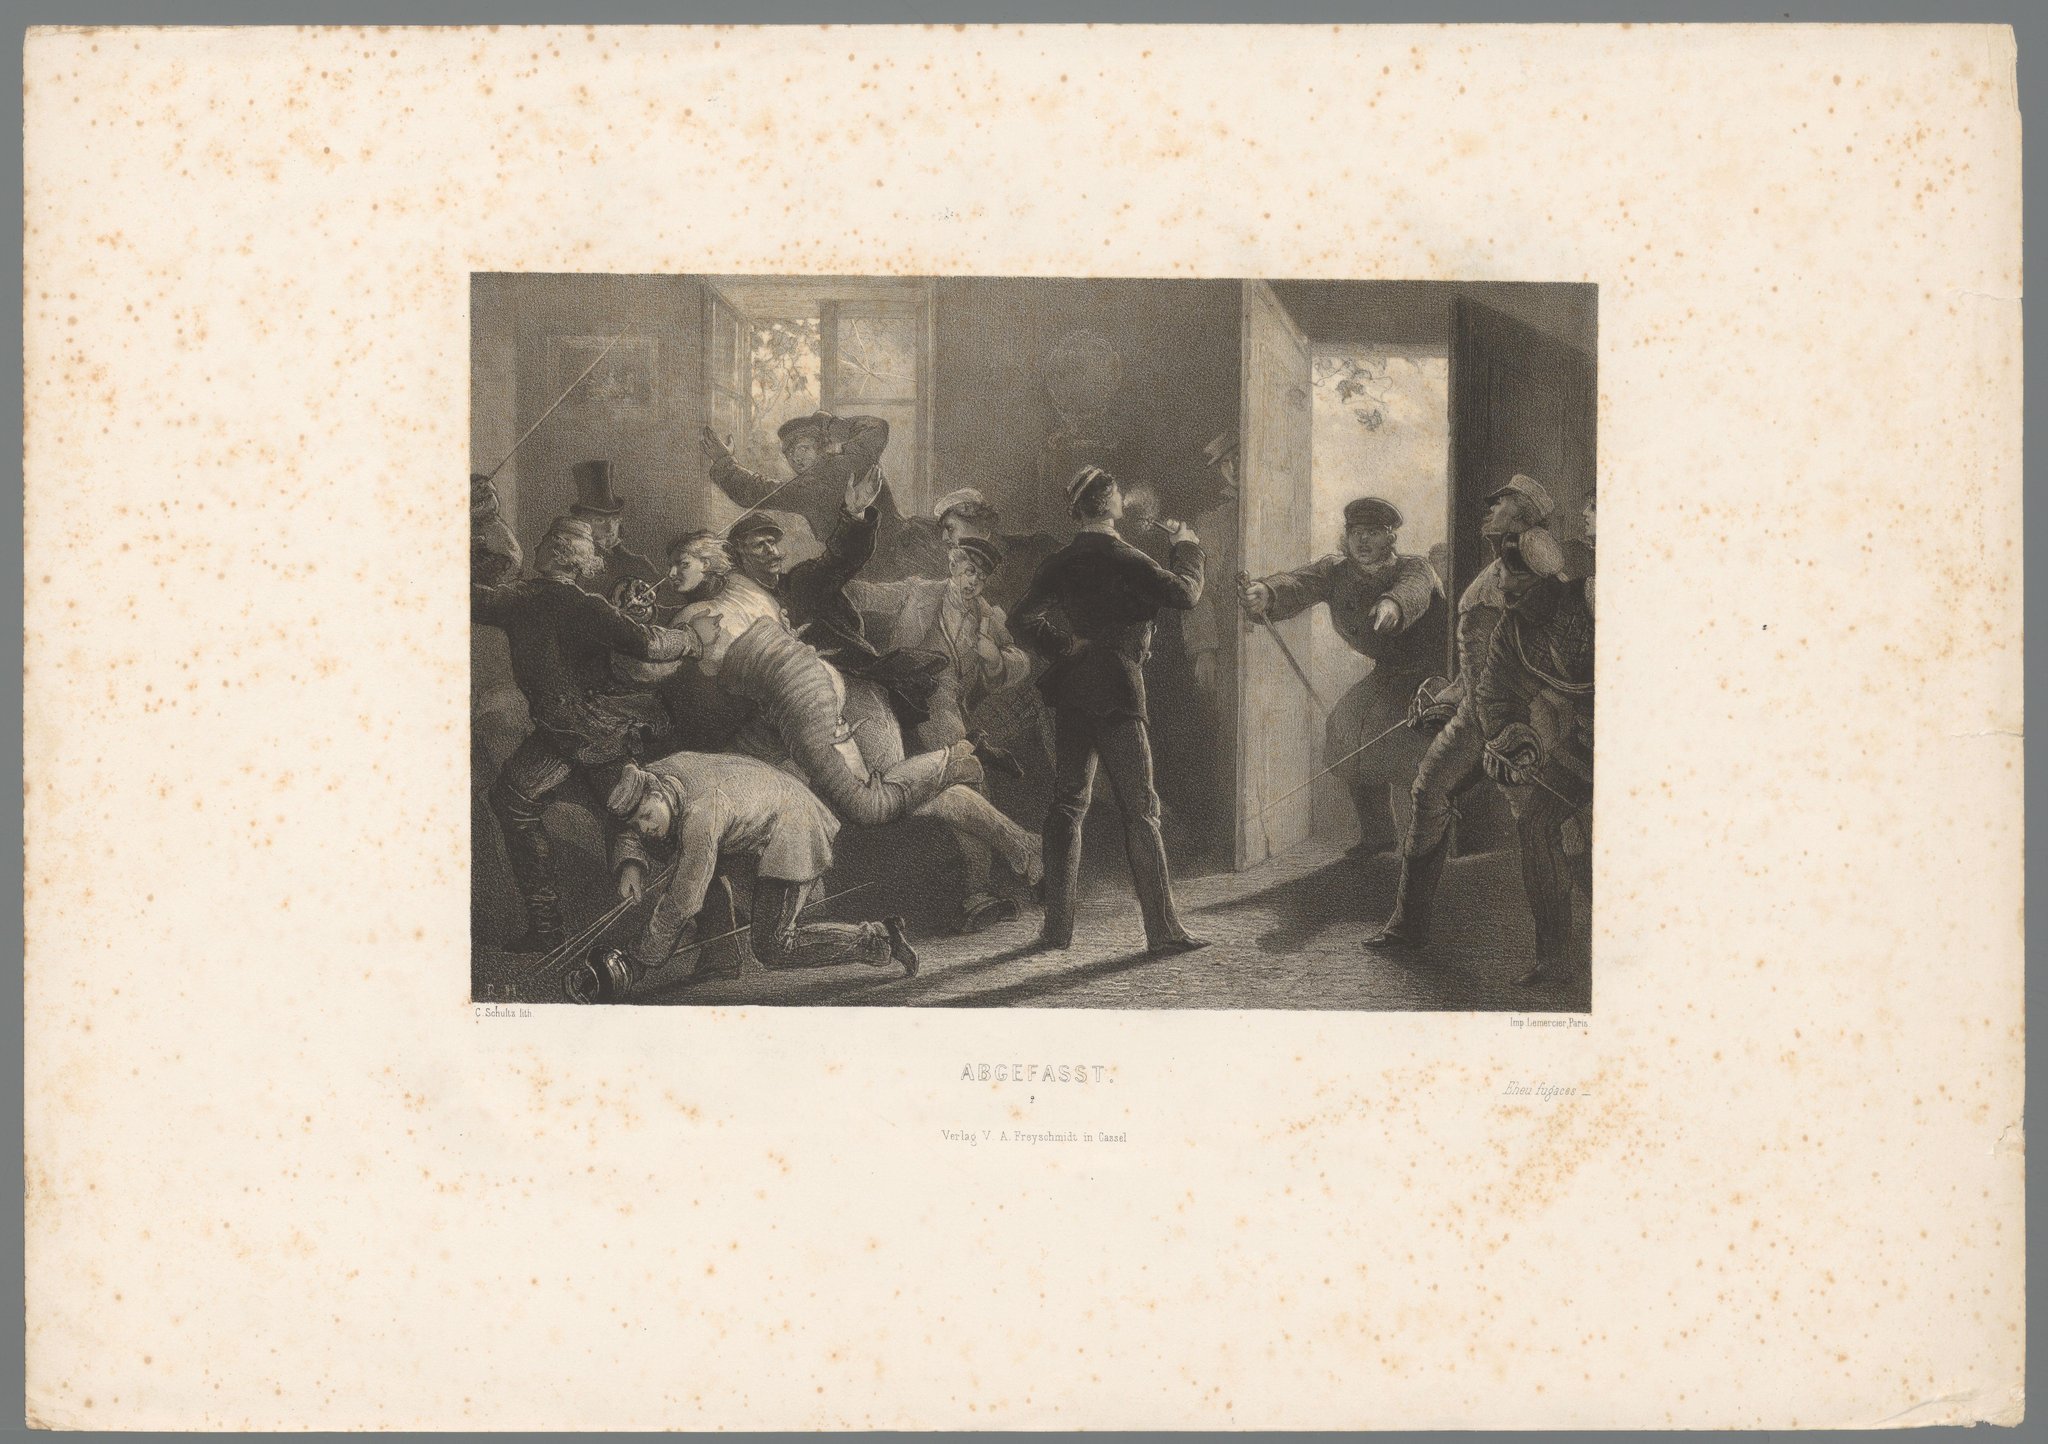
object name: print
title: Bilder aus dem deutschen Studentenleben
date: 1827-1887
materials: paper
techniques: lithograph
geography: kassel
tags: hacking and thrusting weapons, public safety, student life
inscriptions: collector's mark: Lugt 2228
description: Politie valt binnen bij een groep jonge mannen met degens. Onderaan genummerd: 2.